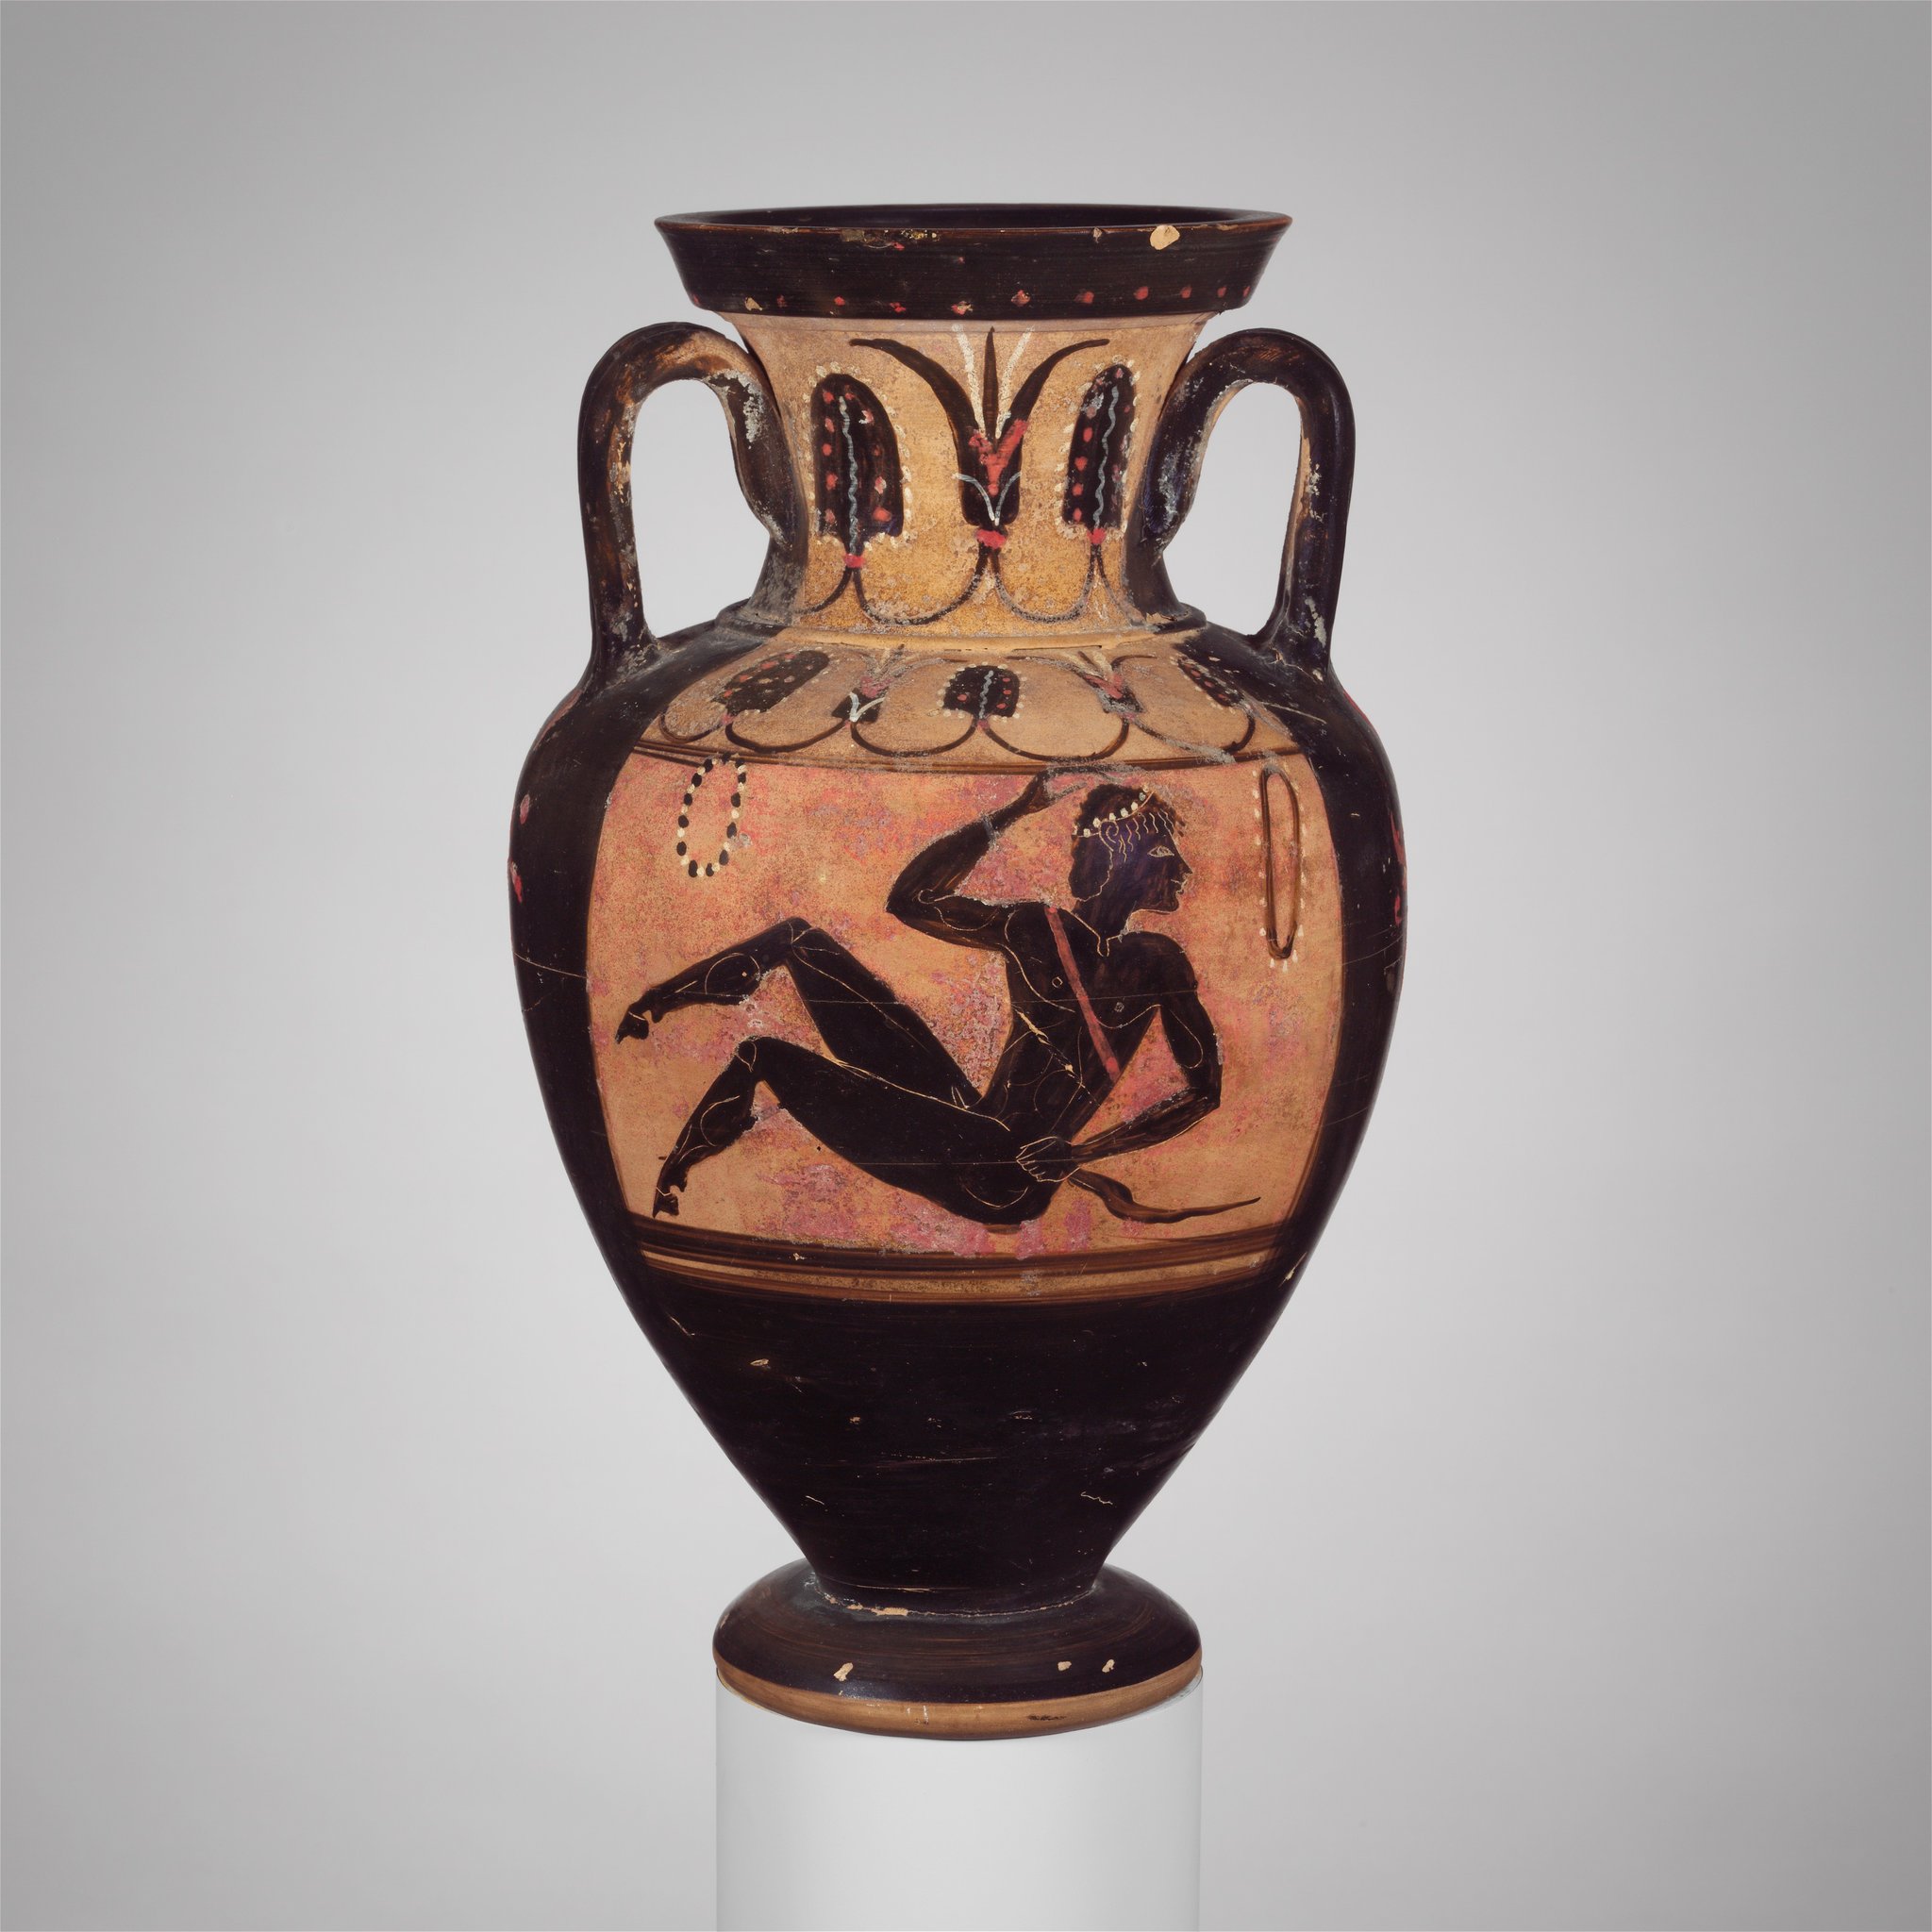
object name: neck amphora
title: Terracotta neck-amphora (jar)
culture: greek or south italian or campanian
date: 500-401 BCE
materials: terracotta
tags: altars,men,satyrs